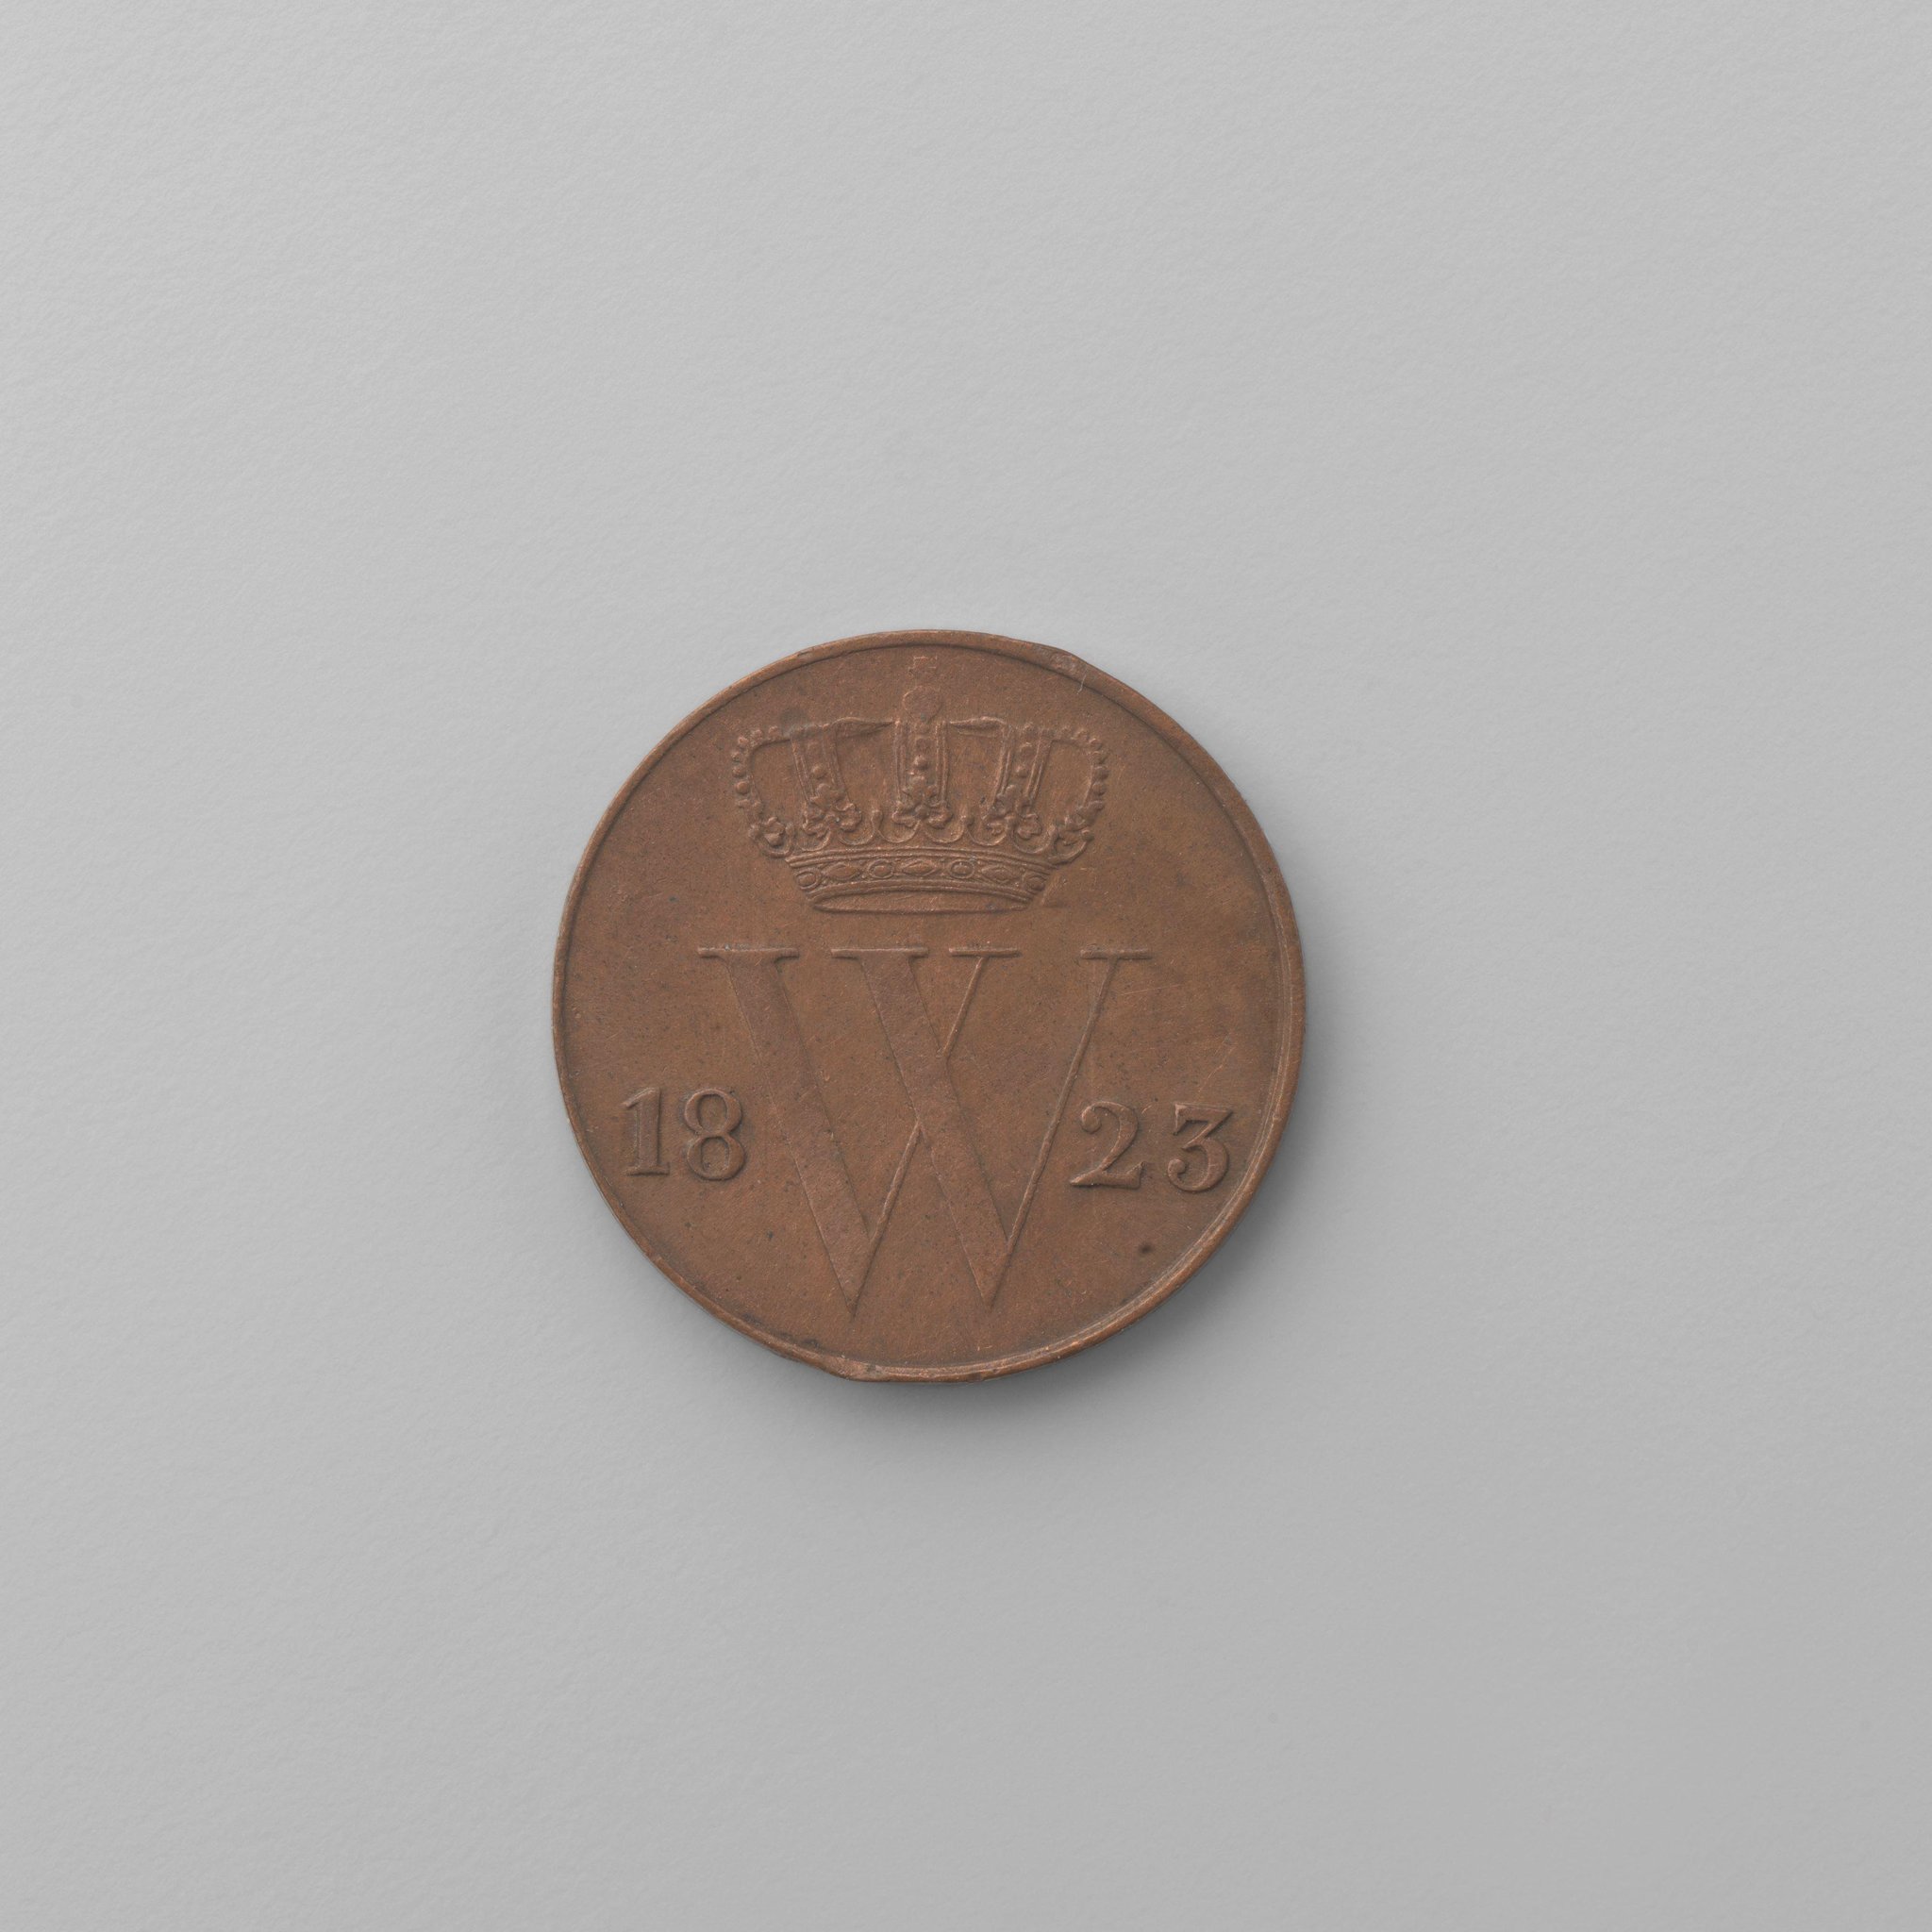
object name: coin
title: Nederland, ½ cent,1823 B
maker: william i of the netherlands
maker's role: koning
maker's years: 1772-1843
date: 1823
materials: copper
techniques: striking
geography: brussels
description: Koperen munt. Voorzijde: tussen jaartal gekroonde rechte letter W. Keerzijde: tussen waarde-aanduiding ½ C. gekroond rijkswapenschild. Gladde rand.